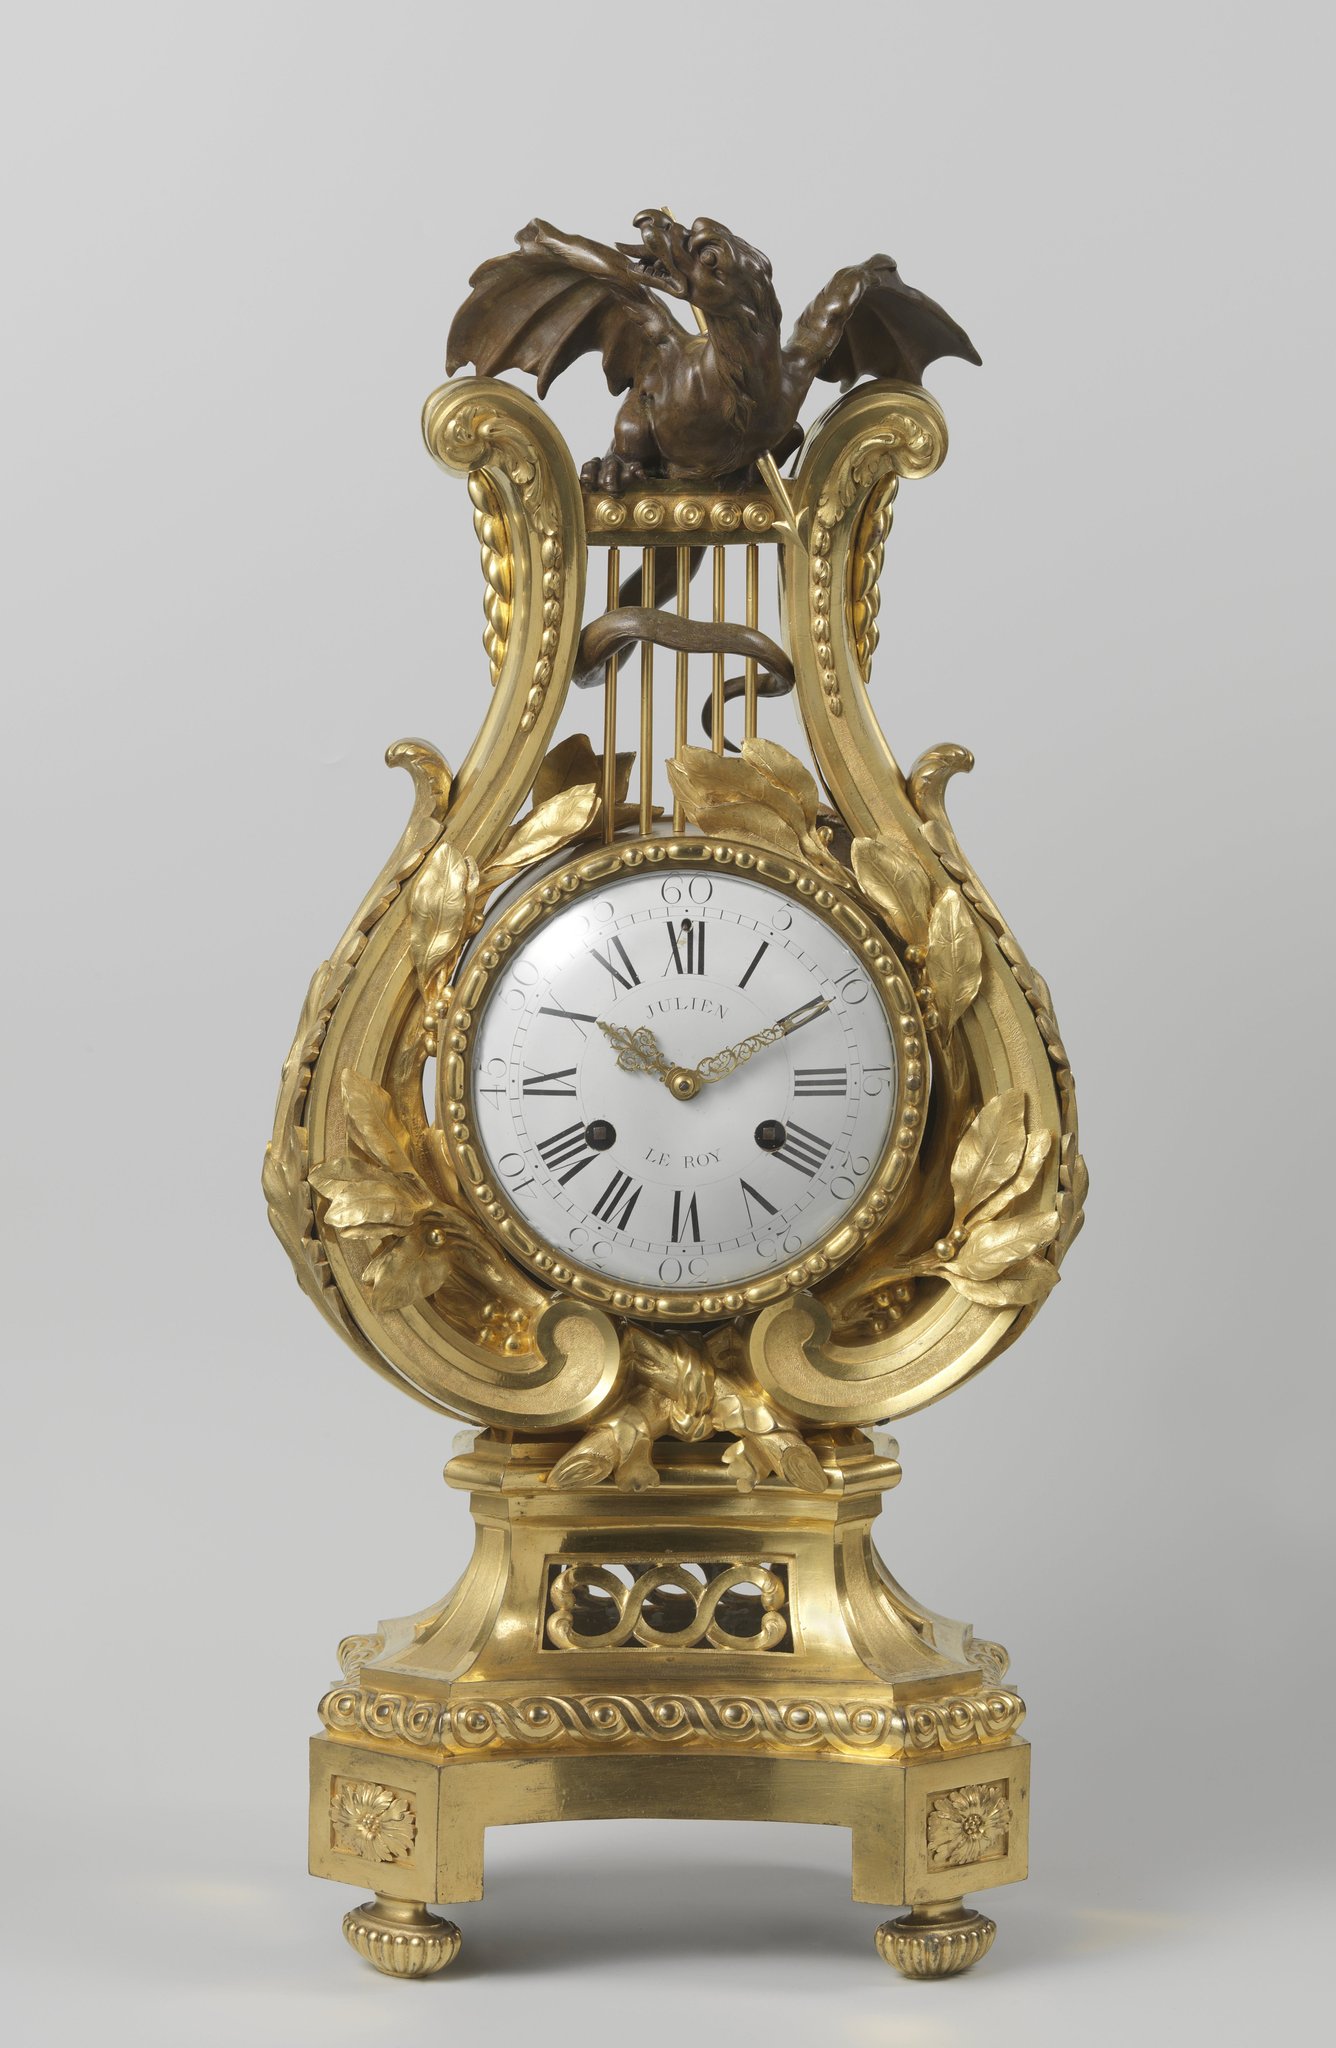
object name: mechanical clock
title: Mantel clock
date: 1768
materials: bronze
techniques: gilding, patinaed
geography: paris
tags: dragon (large fabulous serpent, sometimes with wings and legs)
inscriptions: signature: ‘Julien Le Roy AParis’, inscription: ‘Buzot 8bre 1768 Sonerie’, inscription: ‘Buzot 8bre 1768 Mouvement’, signature: ‘JULIEN/ LE ROY’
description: Large gilt-bronze mantel clocks from Paris were considered symbols of wealth and good taste throughout Europe. For example, in the 18th century, Swedish kings purchased two mantel clocks of this model. The clock’s plain, monumental shape – a lyre with a wounded dragon – is an early example of the Neoclassical style.